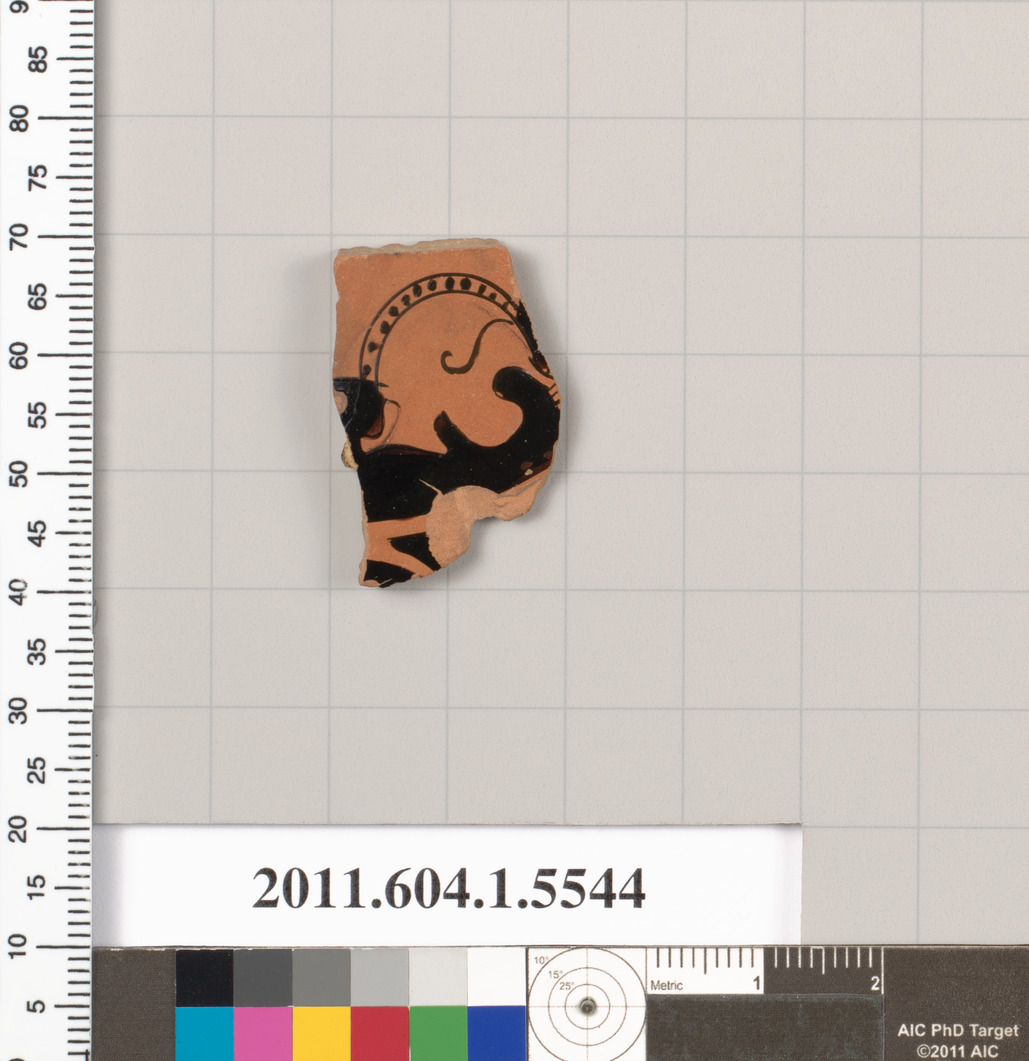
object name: kylix fragment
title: Terracotta fragment of a kylix (drinking cup)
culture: greek, attic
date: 510-490 BCE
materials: terracotta